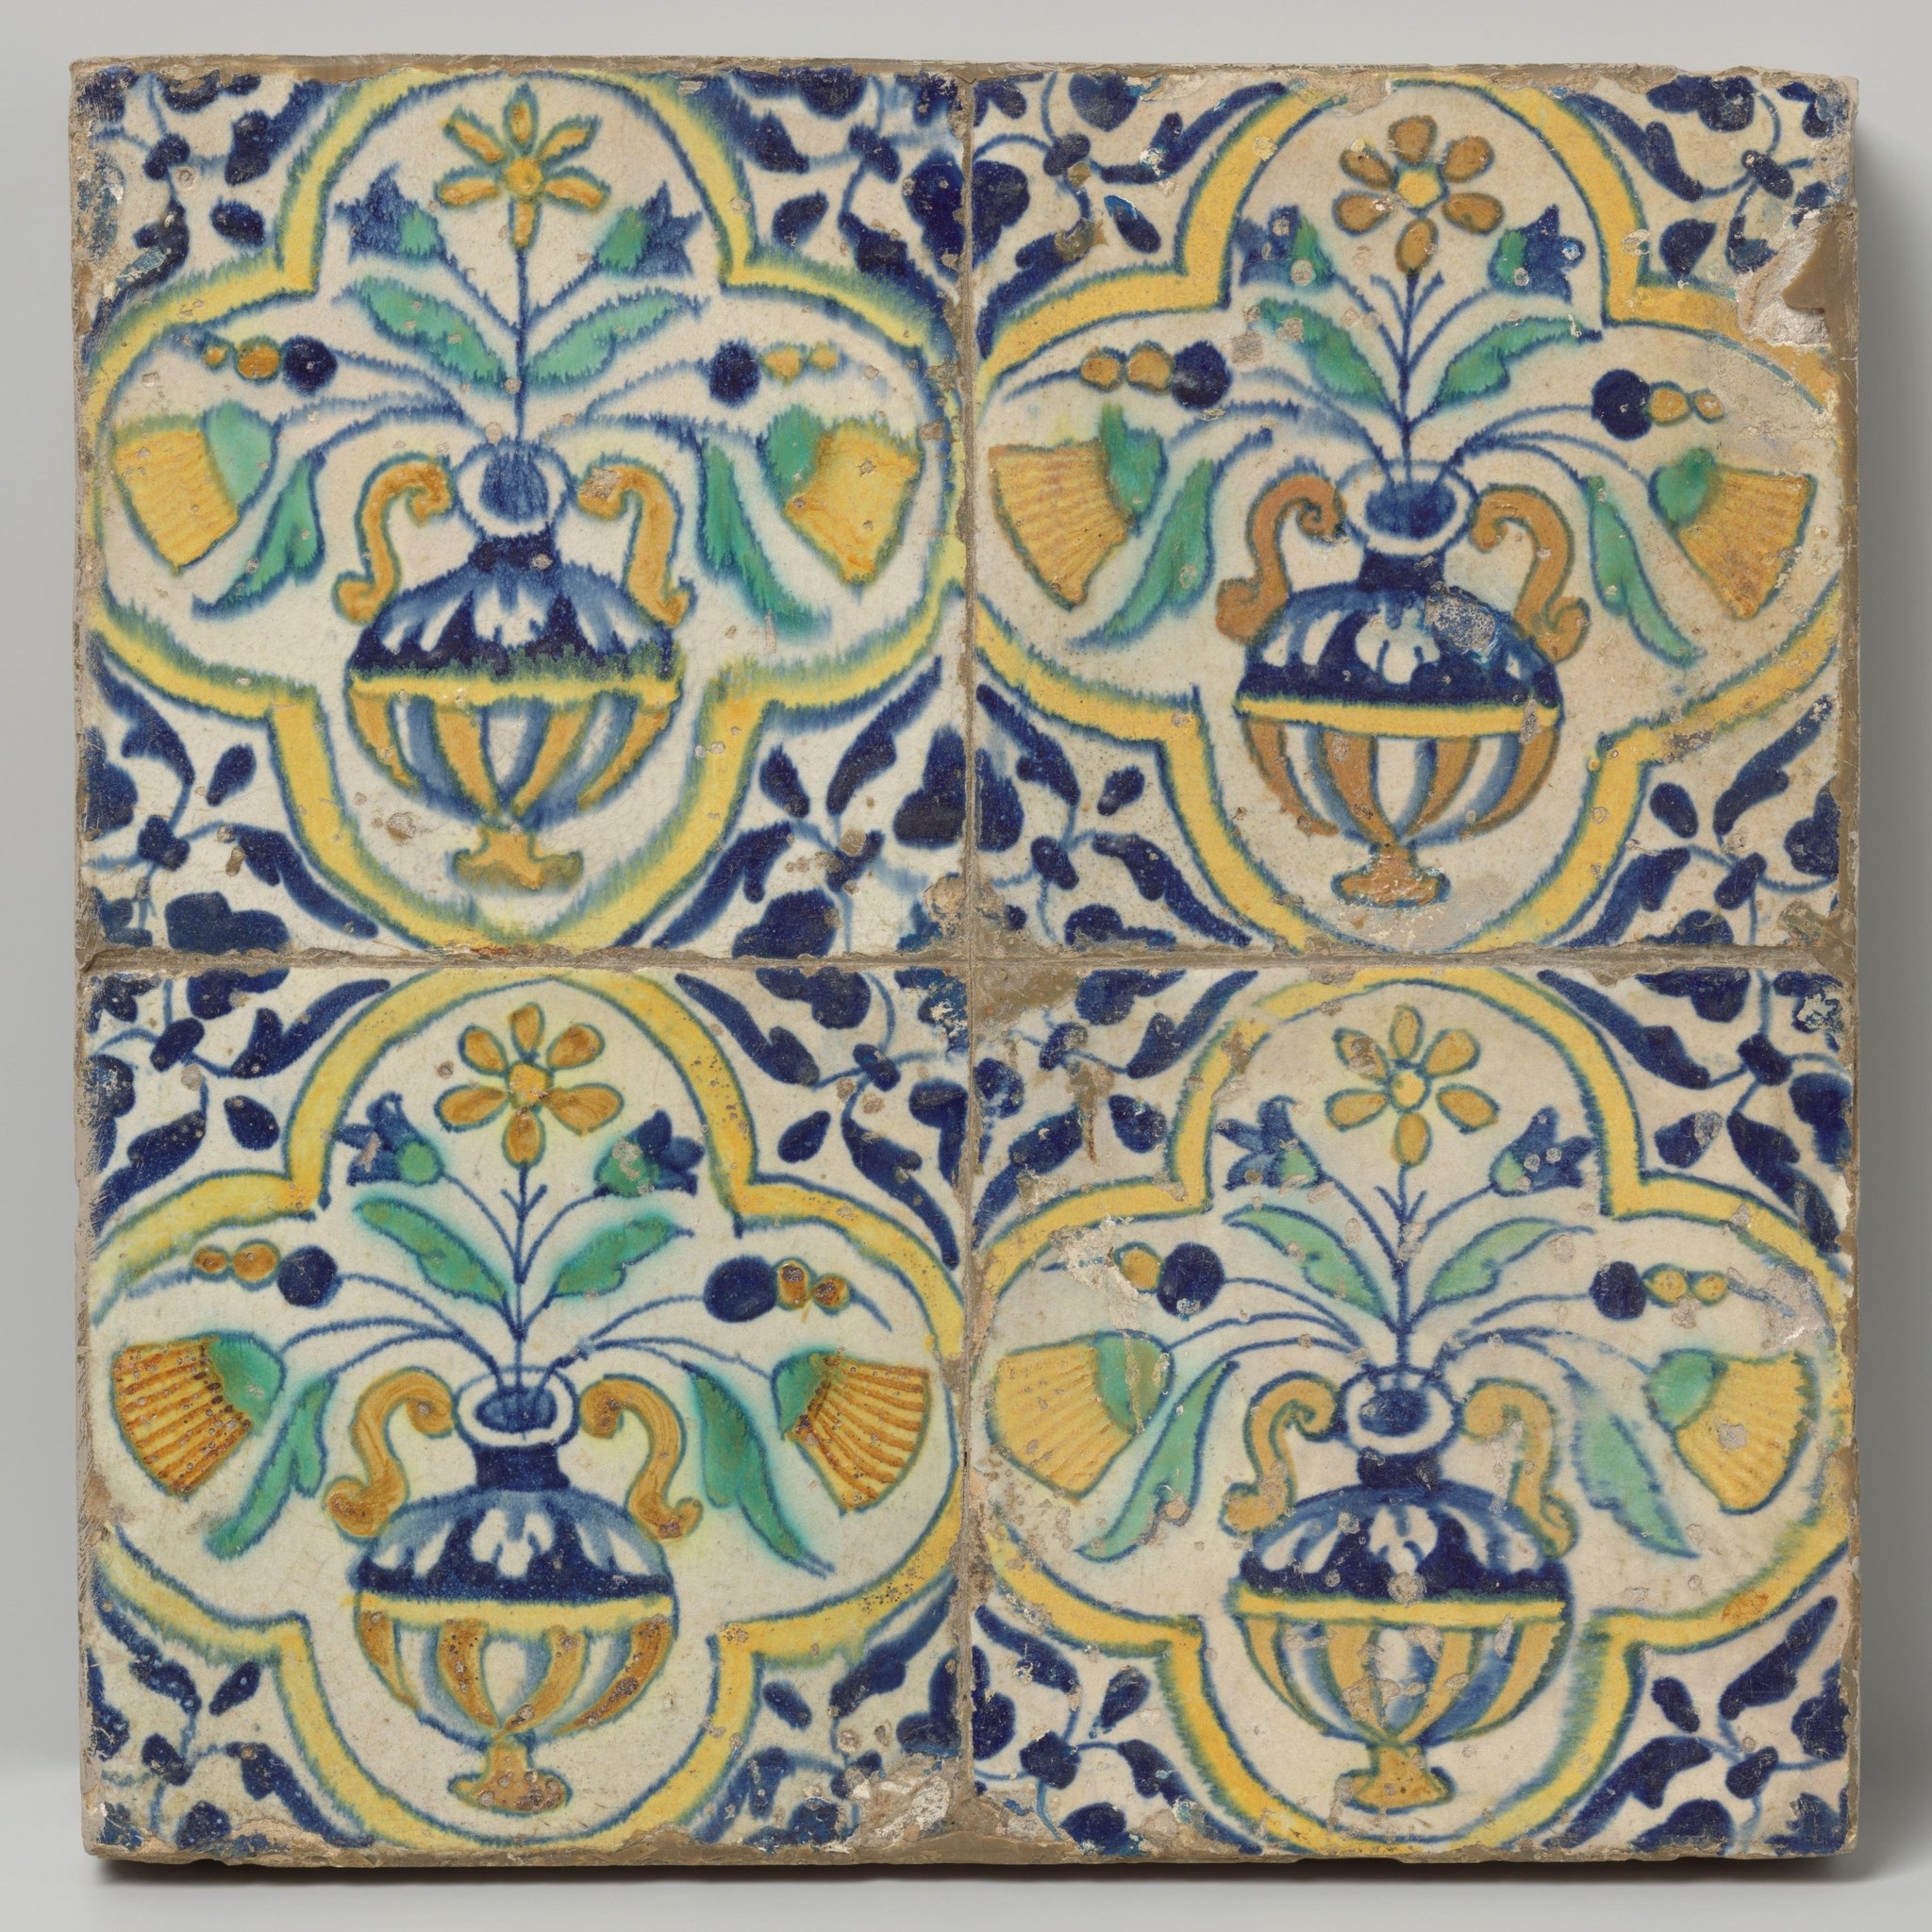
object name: tile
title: Veld van vier pompadourtegels met bloempotten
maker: Anonymous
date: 1610-1625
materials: earthenware, glaze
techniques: maiolica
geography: netherlands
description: Veld van vier pompadourtegels (2 x 2) elk met een veelkleurige (blauw, oranje, groen en geel) bloempot binnen een vierpas omlijsting. In de hoeken, een vleugelblad.